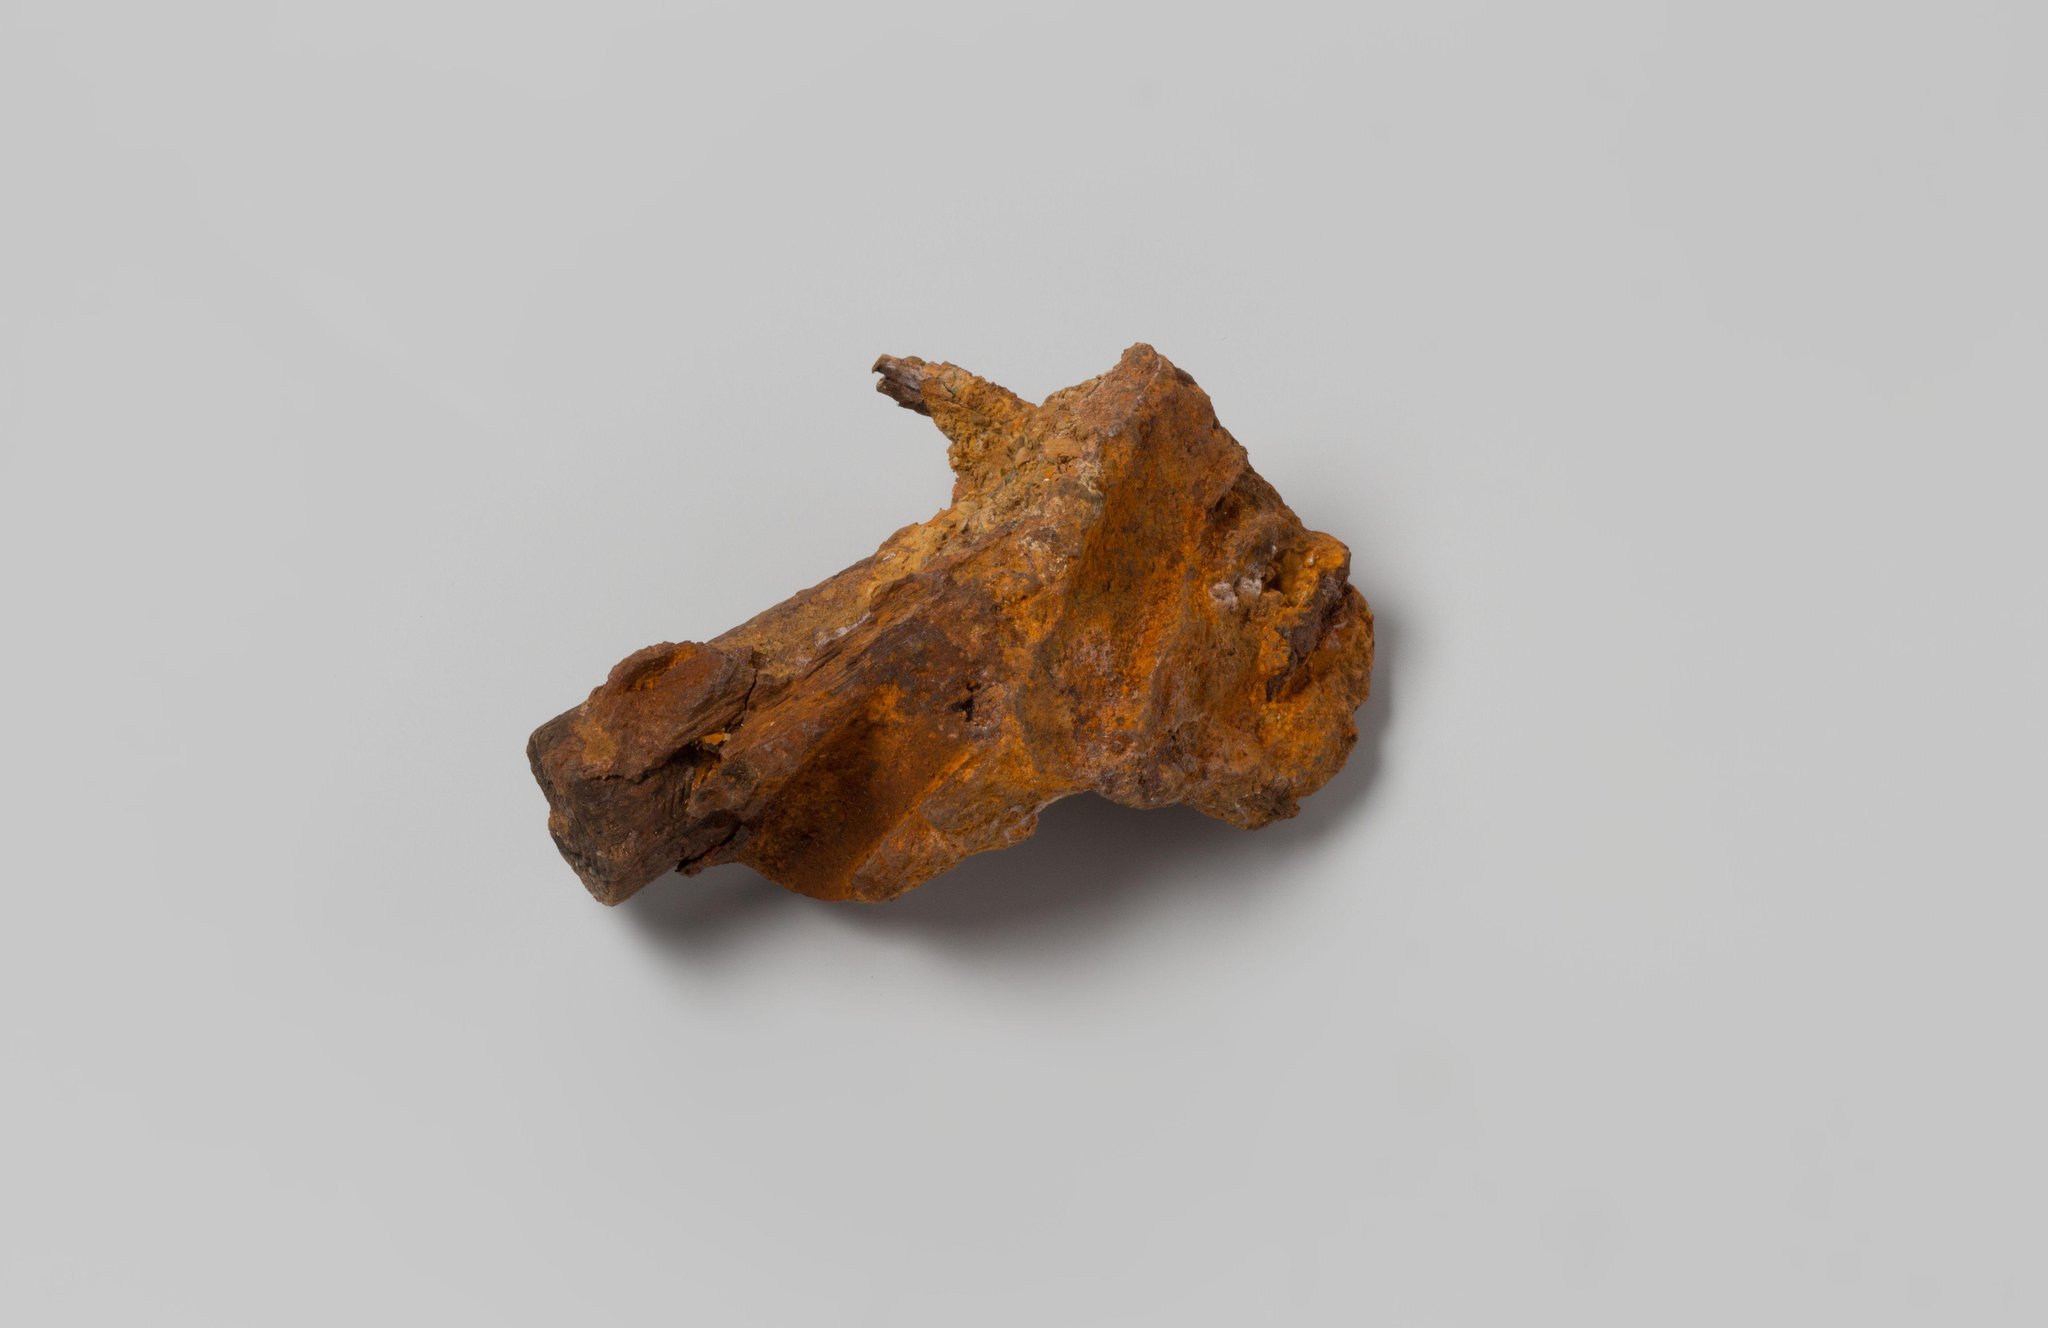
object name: concretionary stone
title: Concretie met fragment houten handvat uit het wrak van de Oost-Indiëvaarder Hollandia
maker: Anonymous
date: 1700-1743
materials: stone, wood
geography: netherlands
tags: verenigde oostindische compagnie, hollandia (schip), annet